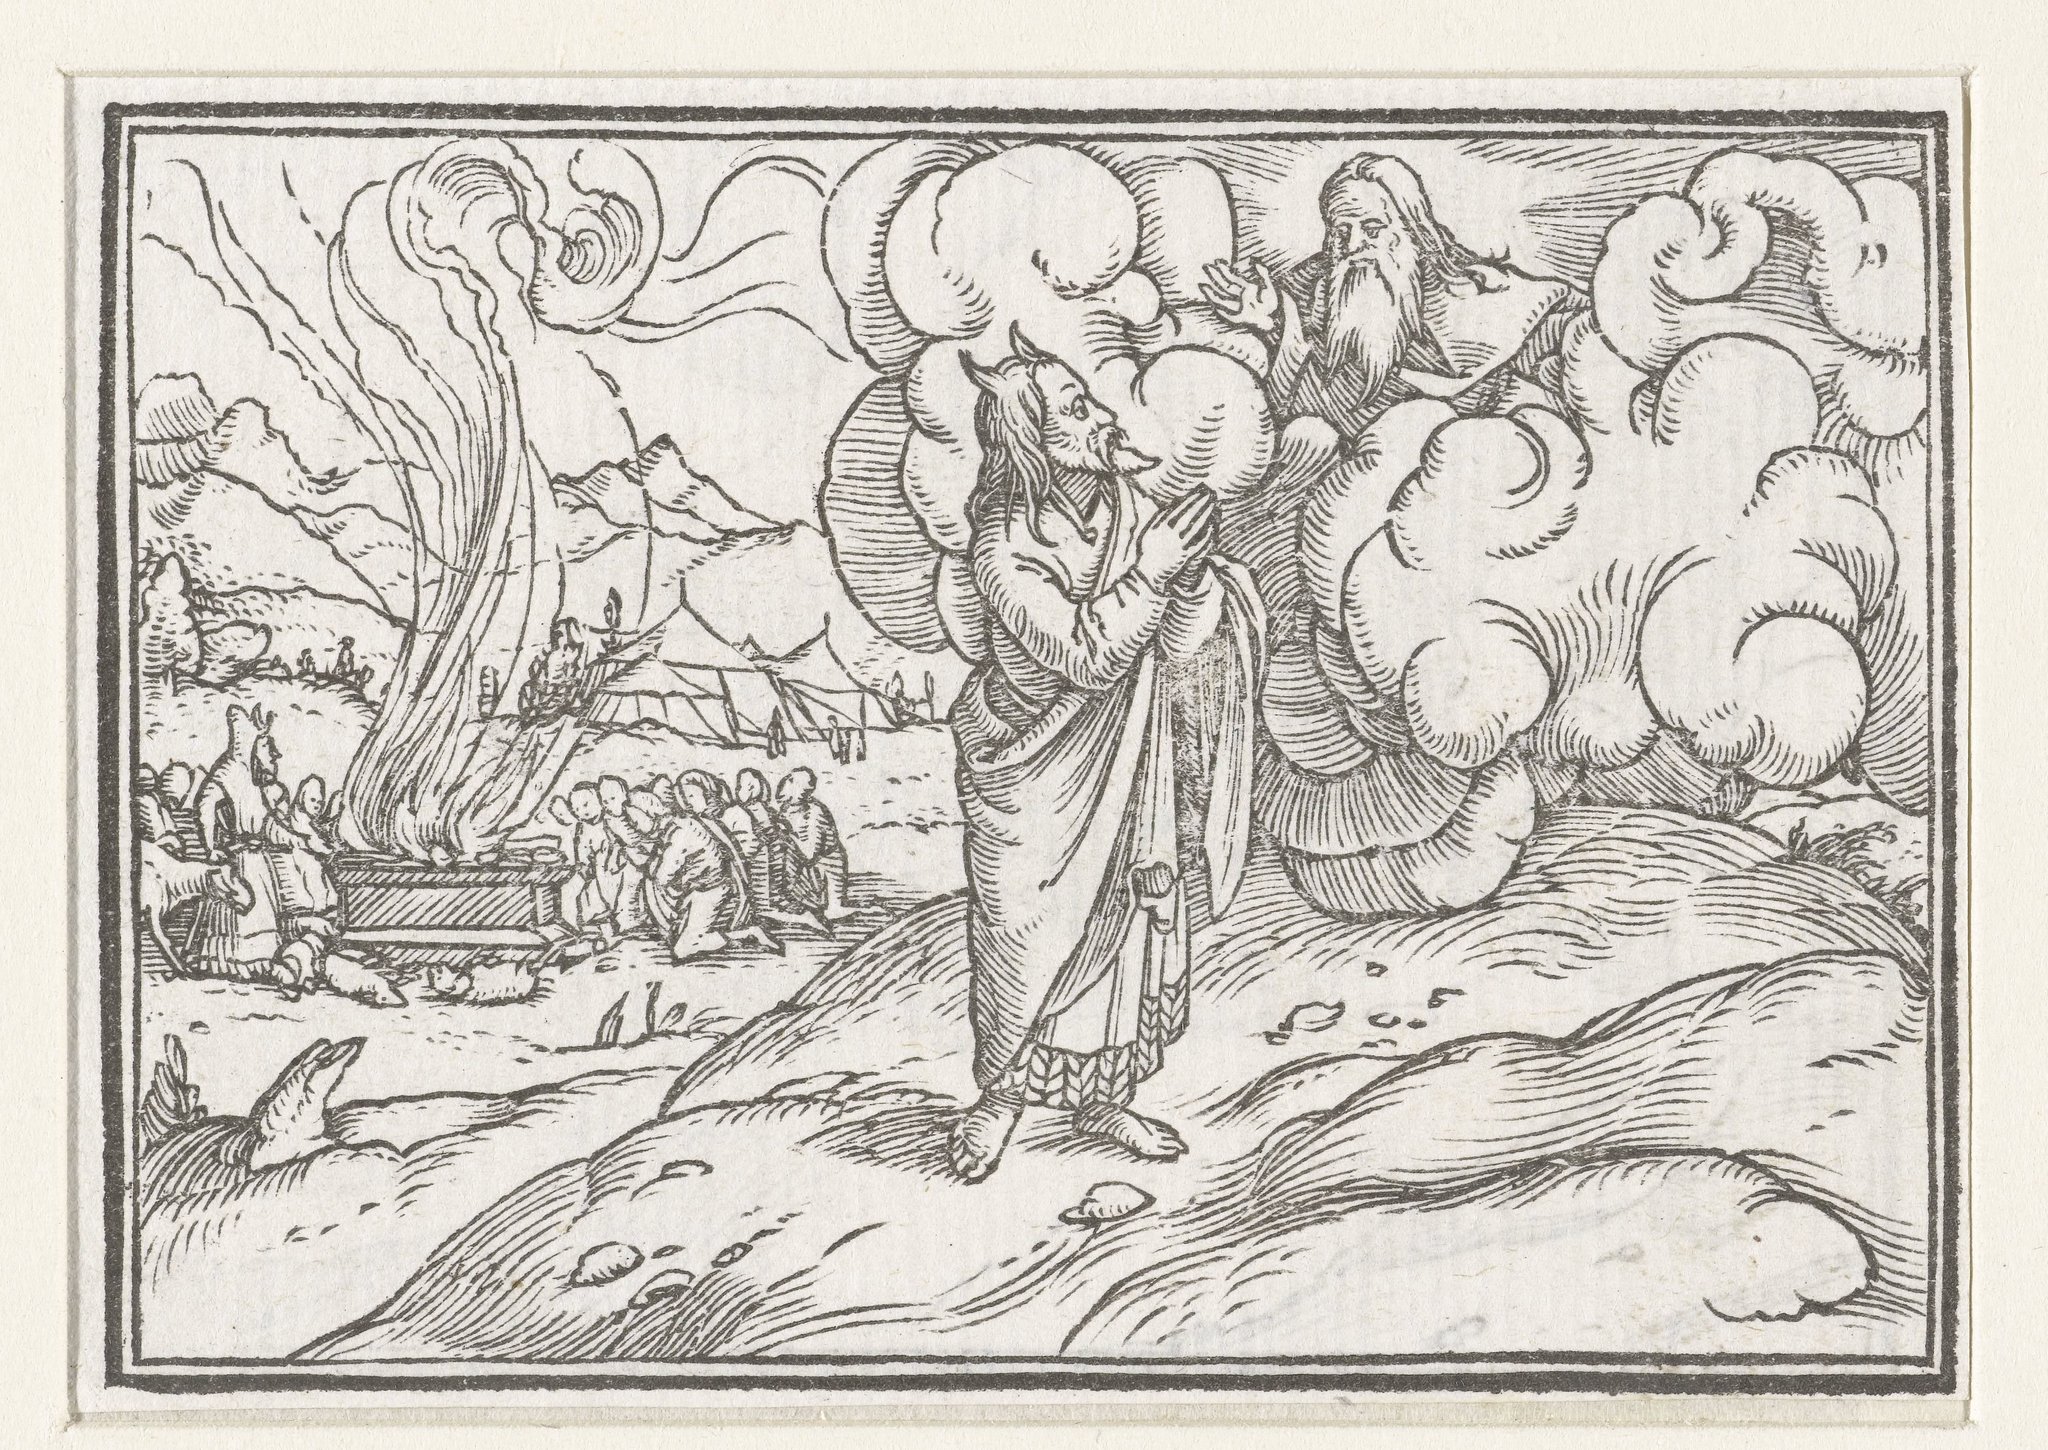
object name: print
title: Mozes leert van God hoe de Israëlieten moeten offeren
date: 1538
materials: paper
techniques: woodcut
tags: moses communicating with god on mount sinai (the mountain may be covered by a thick cloud), the book leviticus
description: Mozes knielt op de berg Sinaï voor God en leert van hem hoe de Israëlieten moeten offeren. Rechts voor het tentenkamp aan de voet van de berg hebben de Israëlieten een offeraltaar gemaakt. In de marge boven de afbeelding staat de tekst Levitici I.